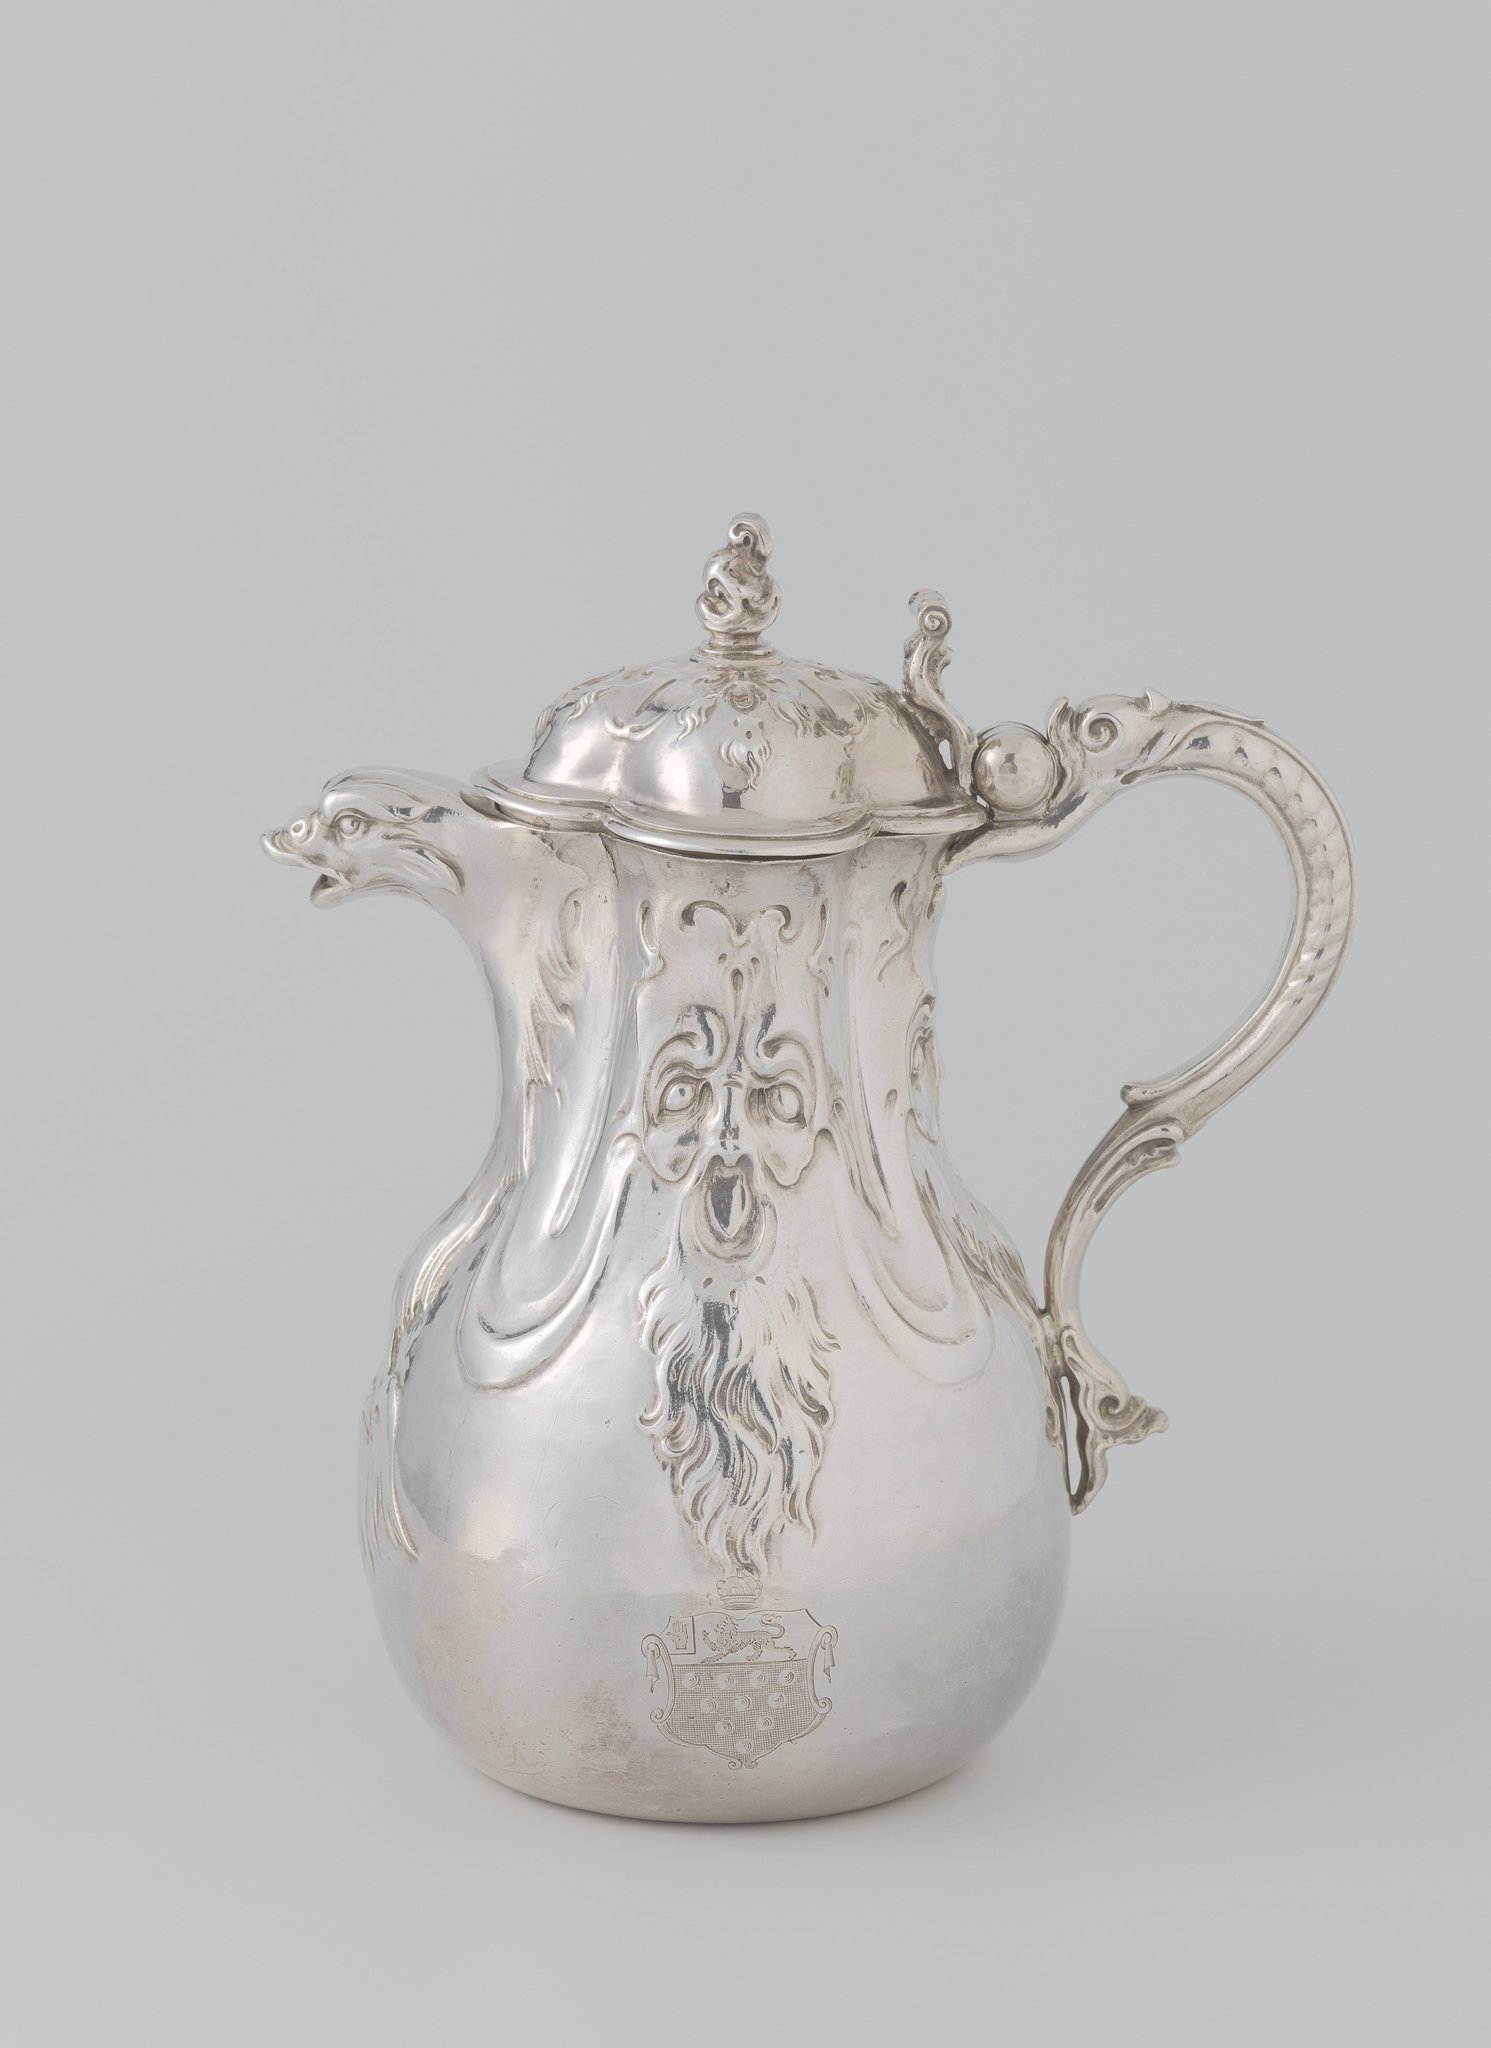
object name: ewer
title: Two Jugs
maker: christiaen van vianen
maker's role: silversmith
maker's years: 1600-1667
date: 1660-1665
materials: silver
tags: mask, mascaron ~ ornament, dragon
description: Christiaen lived in Utrecht during the British Civil War (1642-1660), but afterwards he returned to London where he worked together with John Cooqus, who married his daughter. Christiaen probably collaborated on the jug at the left. The one at the right, which is less well finished, is probably solely Cooqus’s work. Kwab ornament is still very prominent in these late pieces.